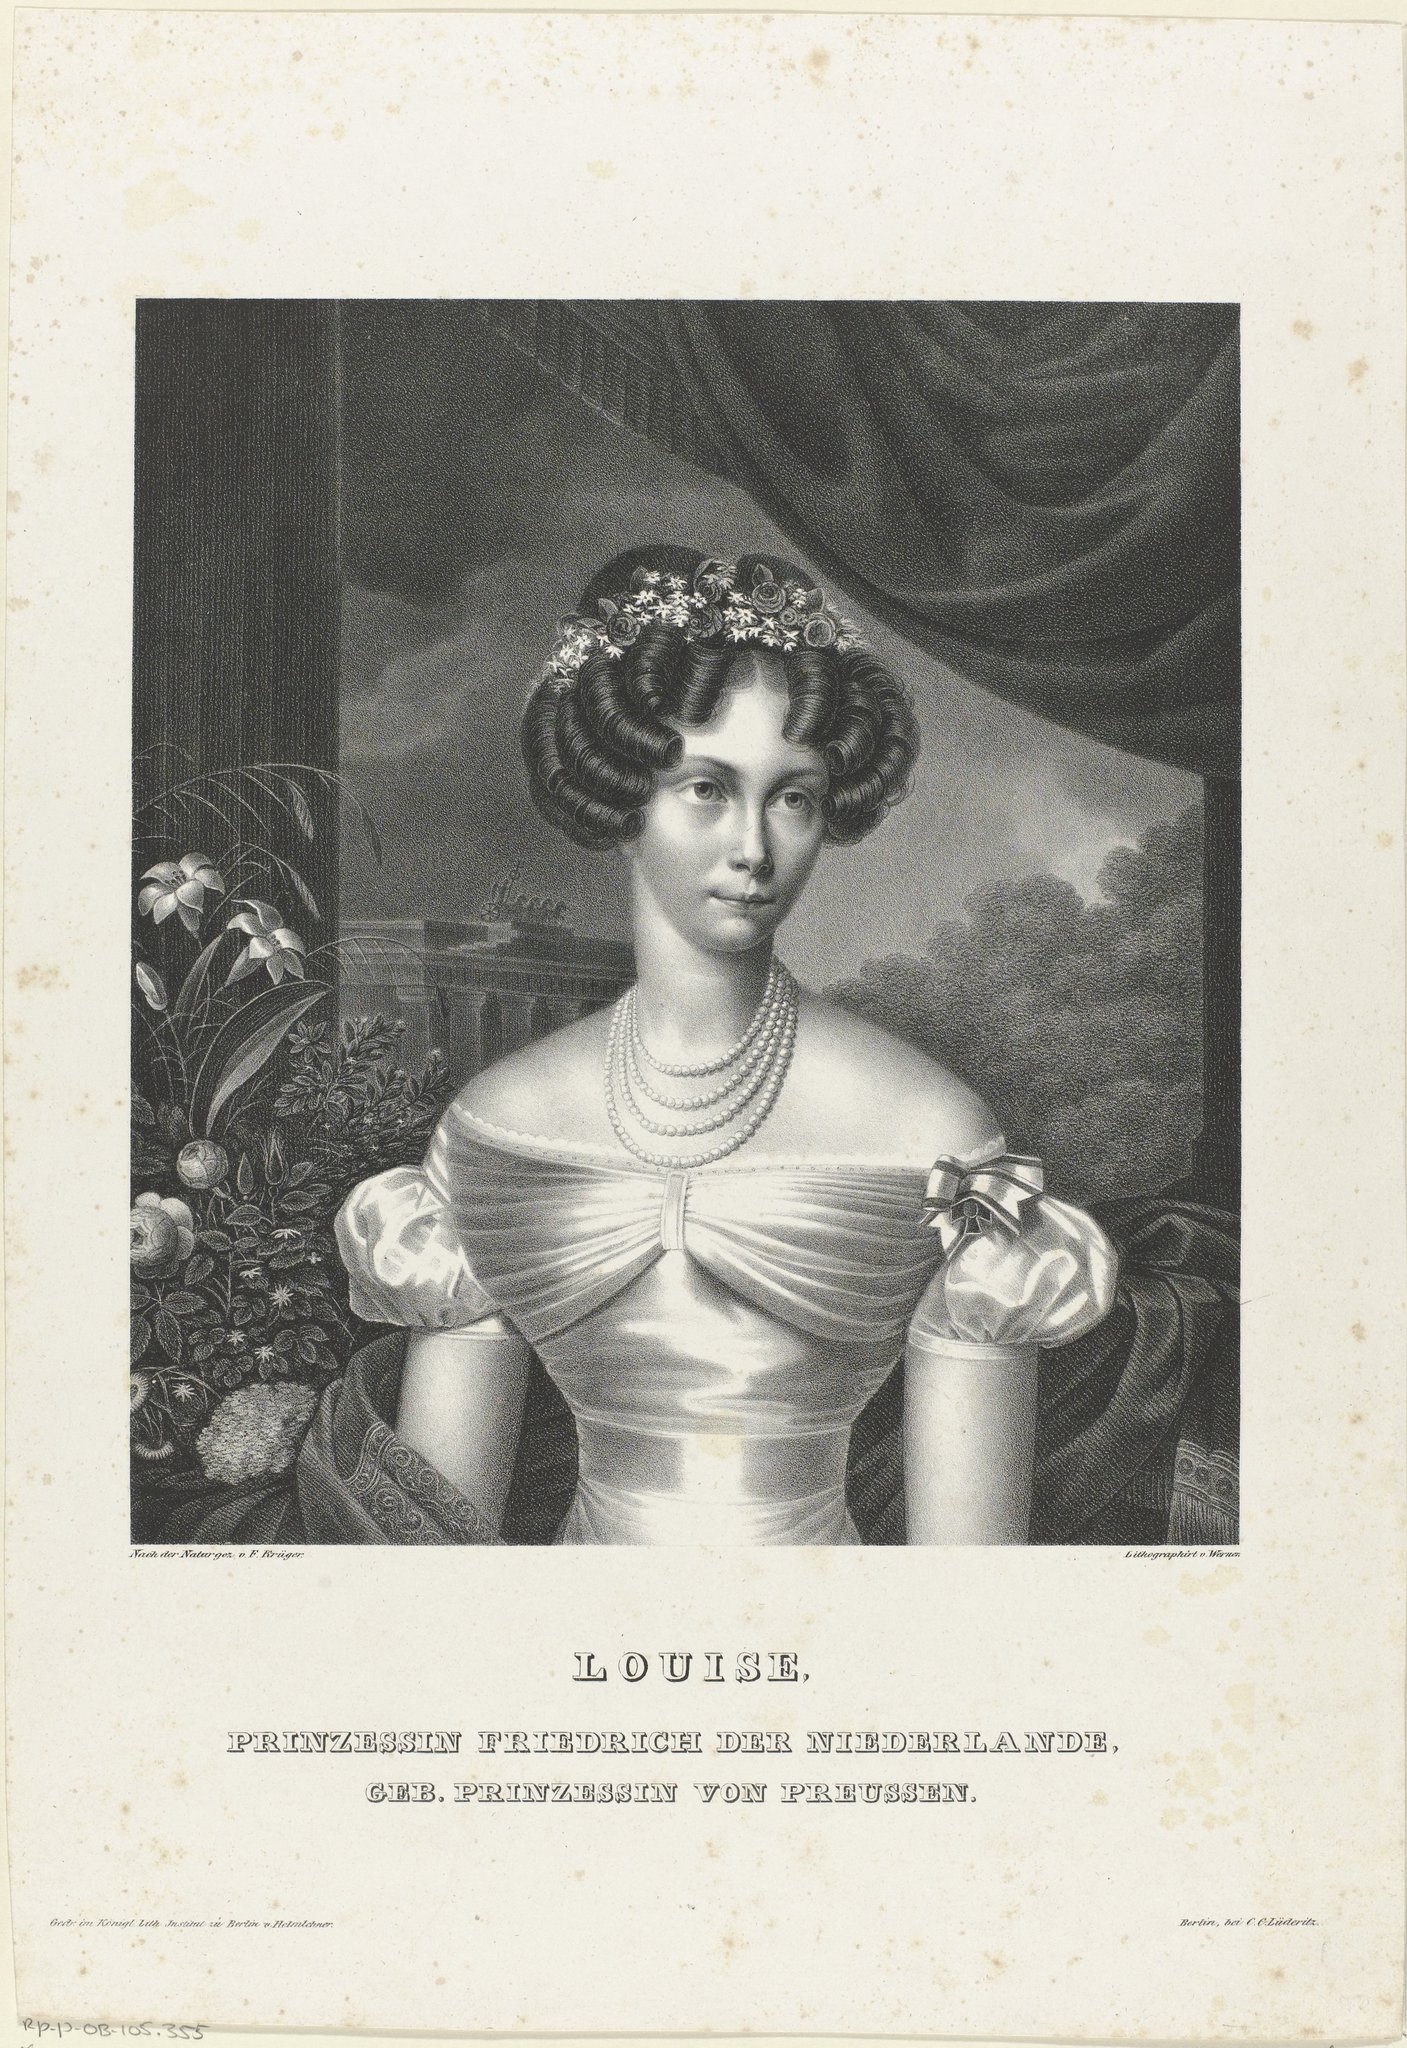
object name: print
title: Portret van Louise van Pruisen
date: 1823-1837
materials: paper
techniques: lithograph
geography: berlin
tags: koningsbergen, wassenaar, prinses, louise van pruisen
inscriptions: collector's mark: Lugt 963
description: Portret van Louise. Op de achtergrond een doorkijkje. In de ondermarge haar naam en titels.